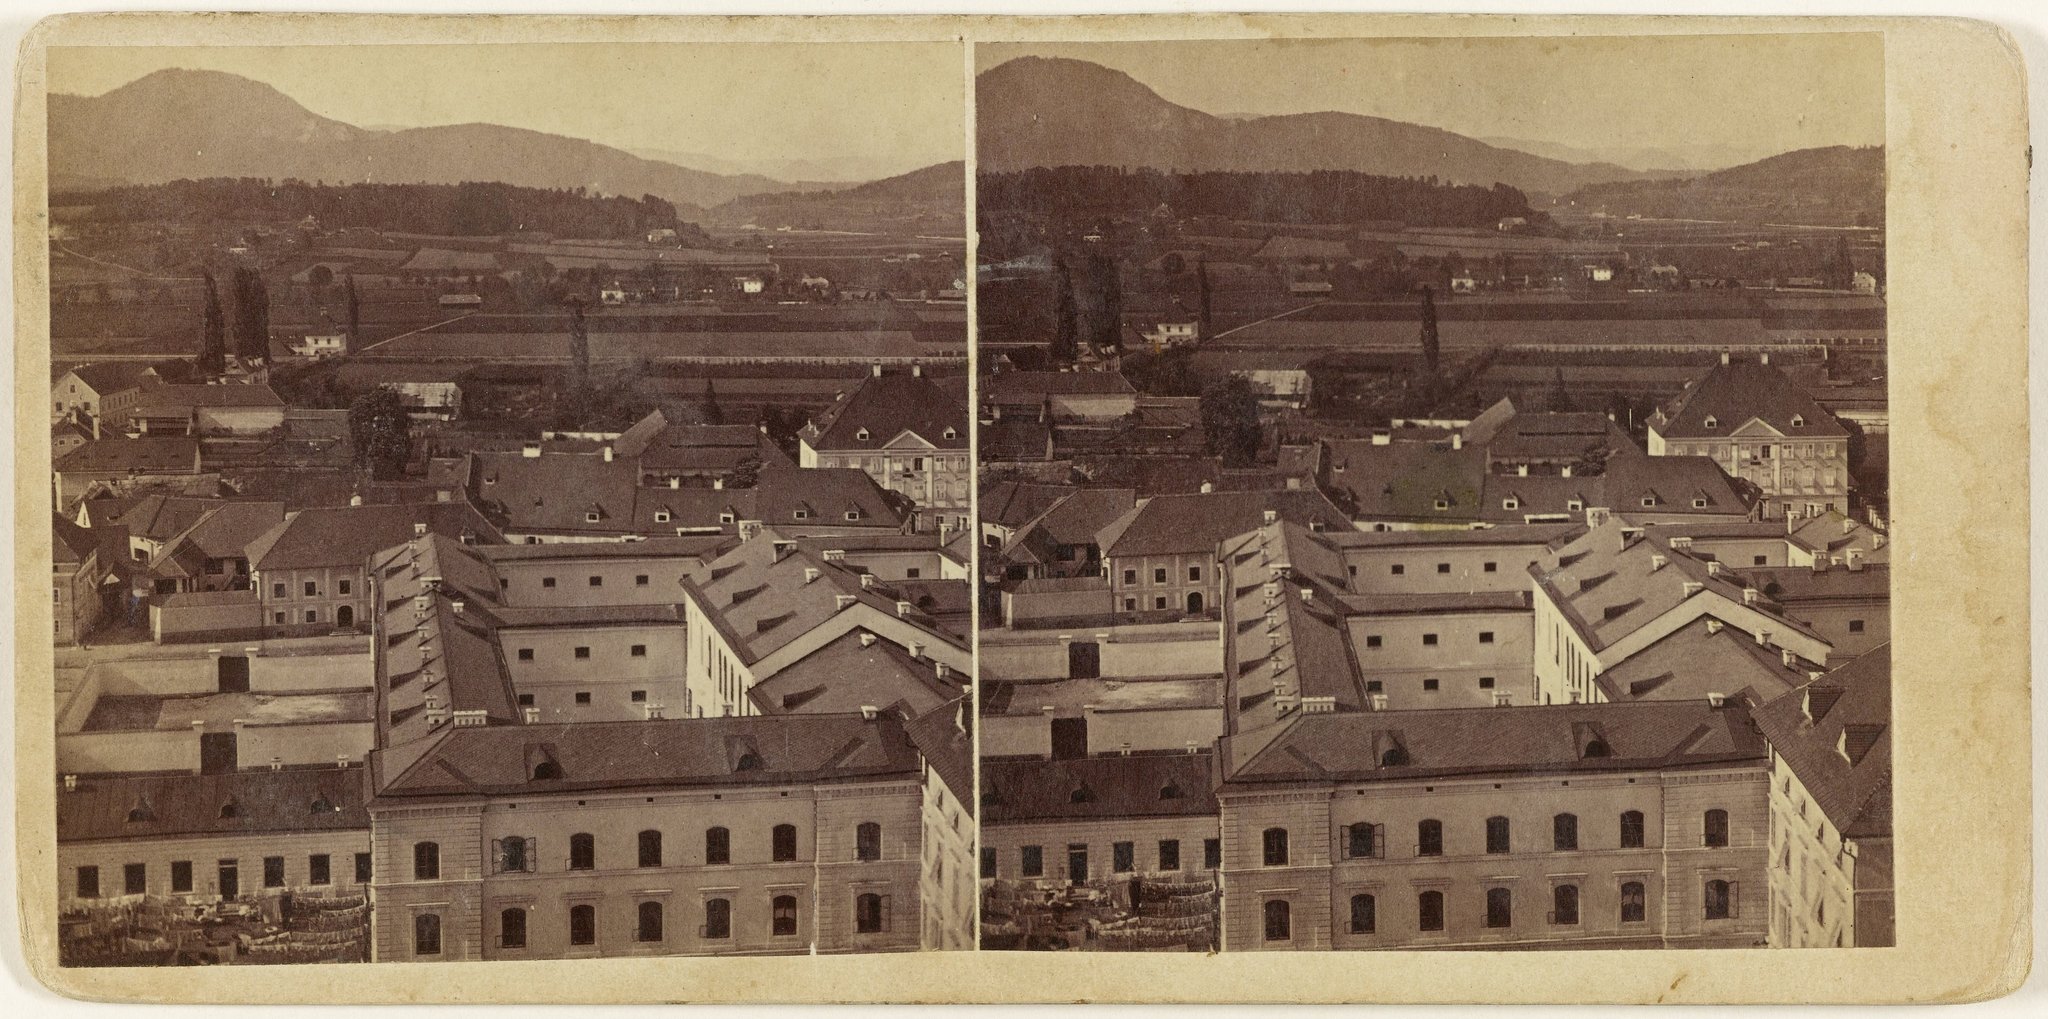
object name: stereograph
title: View of Klagenfurt, Austria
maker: Anonymous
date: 1860-1880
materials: cardboard, paper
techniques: albumen print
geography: klagenfurt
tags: prospect of city, town panorama, silhouette of city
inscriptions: annotation: ‘Panorama von Klagenfurt // Norden’